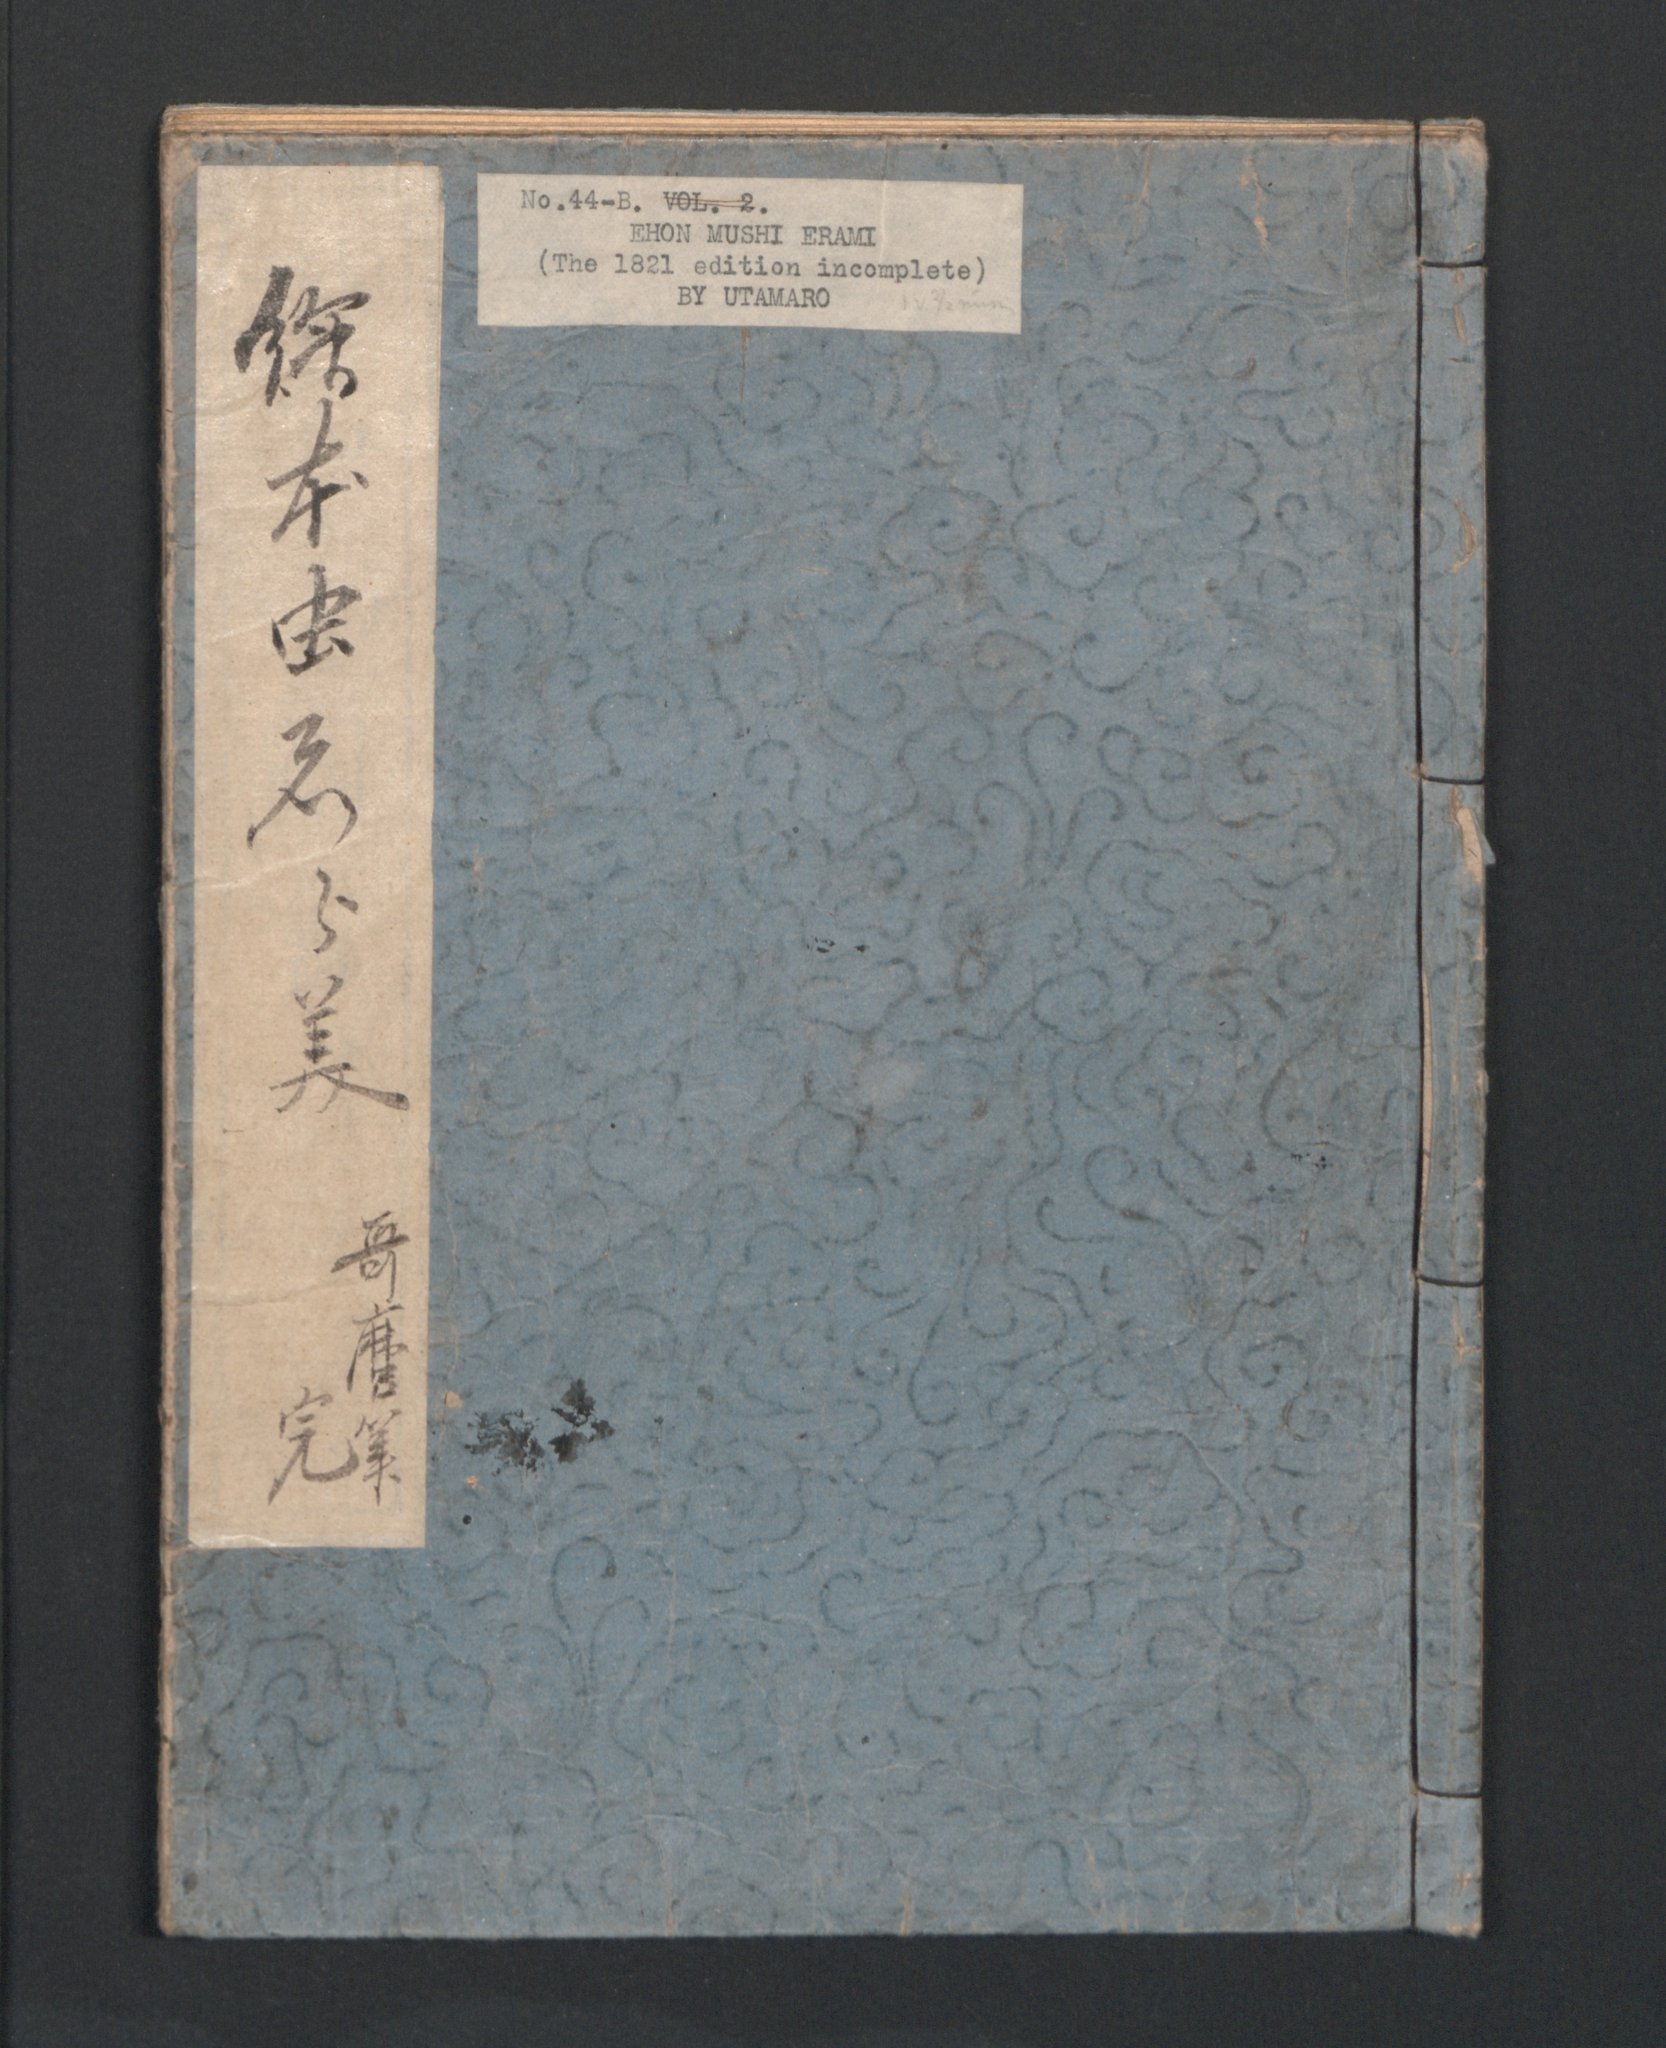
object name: illustrated book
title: Picture Book of Crawling Creatures (The Insect Book) (Ehon mushi erami) 画本虫撰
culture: japanese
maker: kitagawa utamaro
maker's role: artist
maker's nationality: japanese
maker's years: 1754-1806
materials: ink, paper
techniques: polychrome, woodblock print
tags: frogs,insects